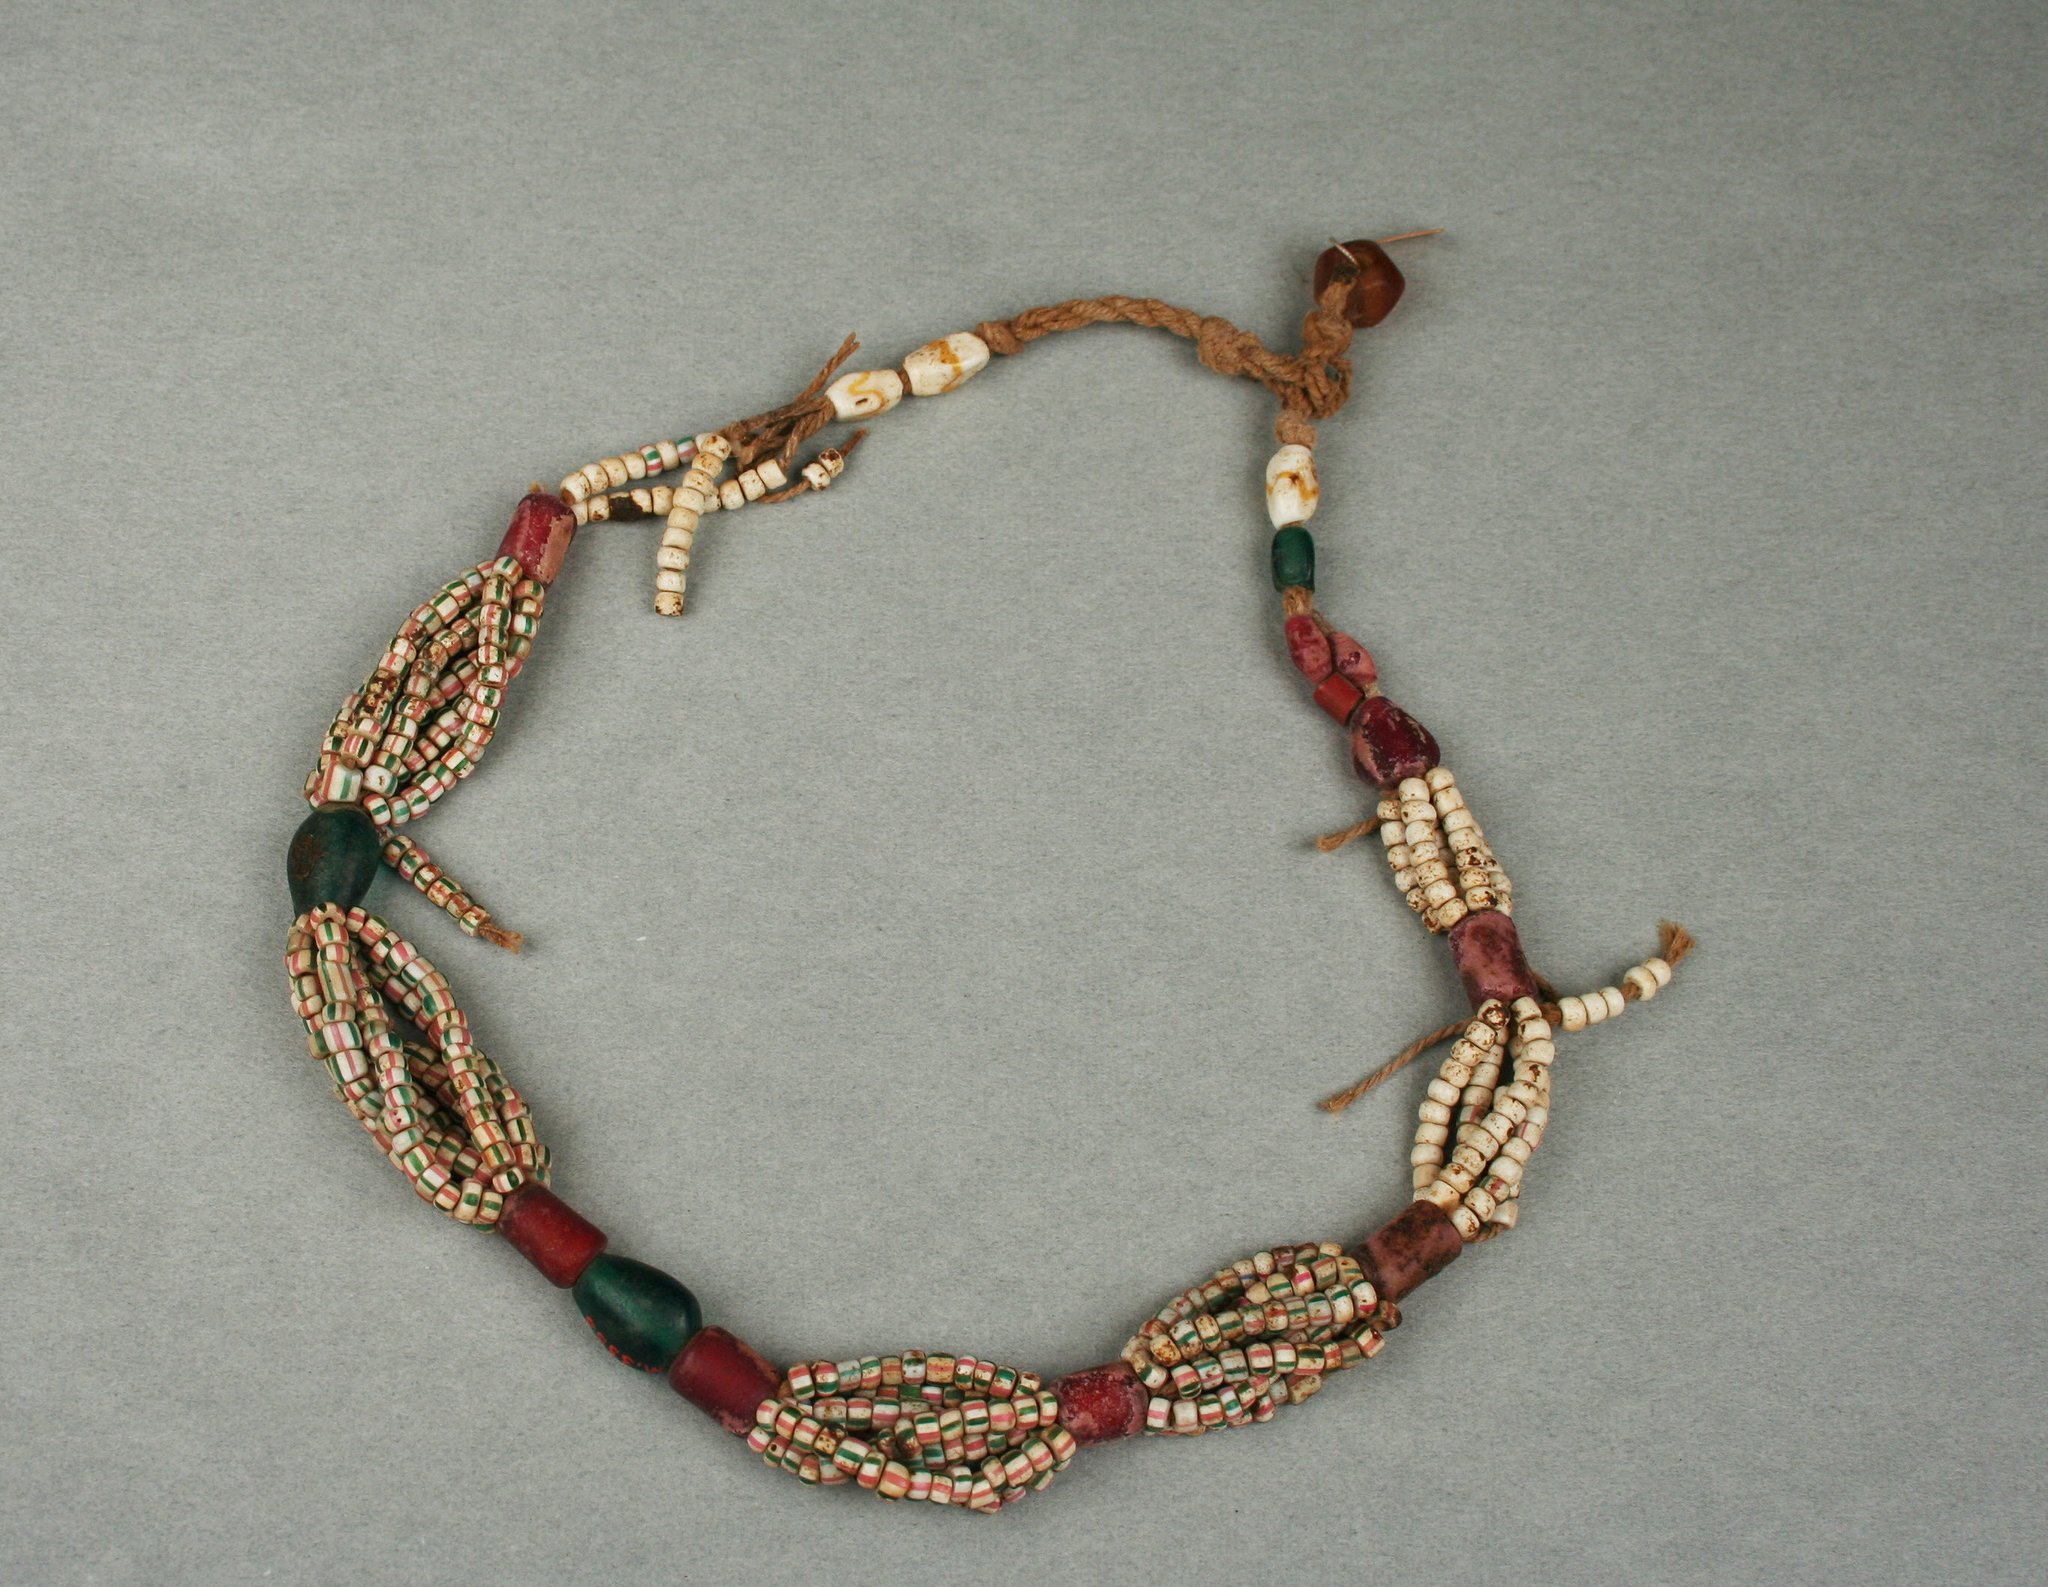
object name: necklace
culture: african or european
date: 1767-1900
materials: glass, ivory